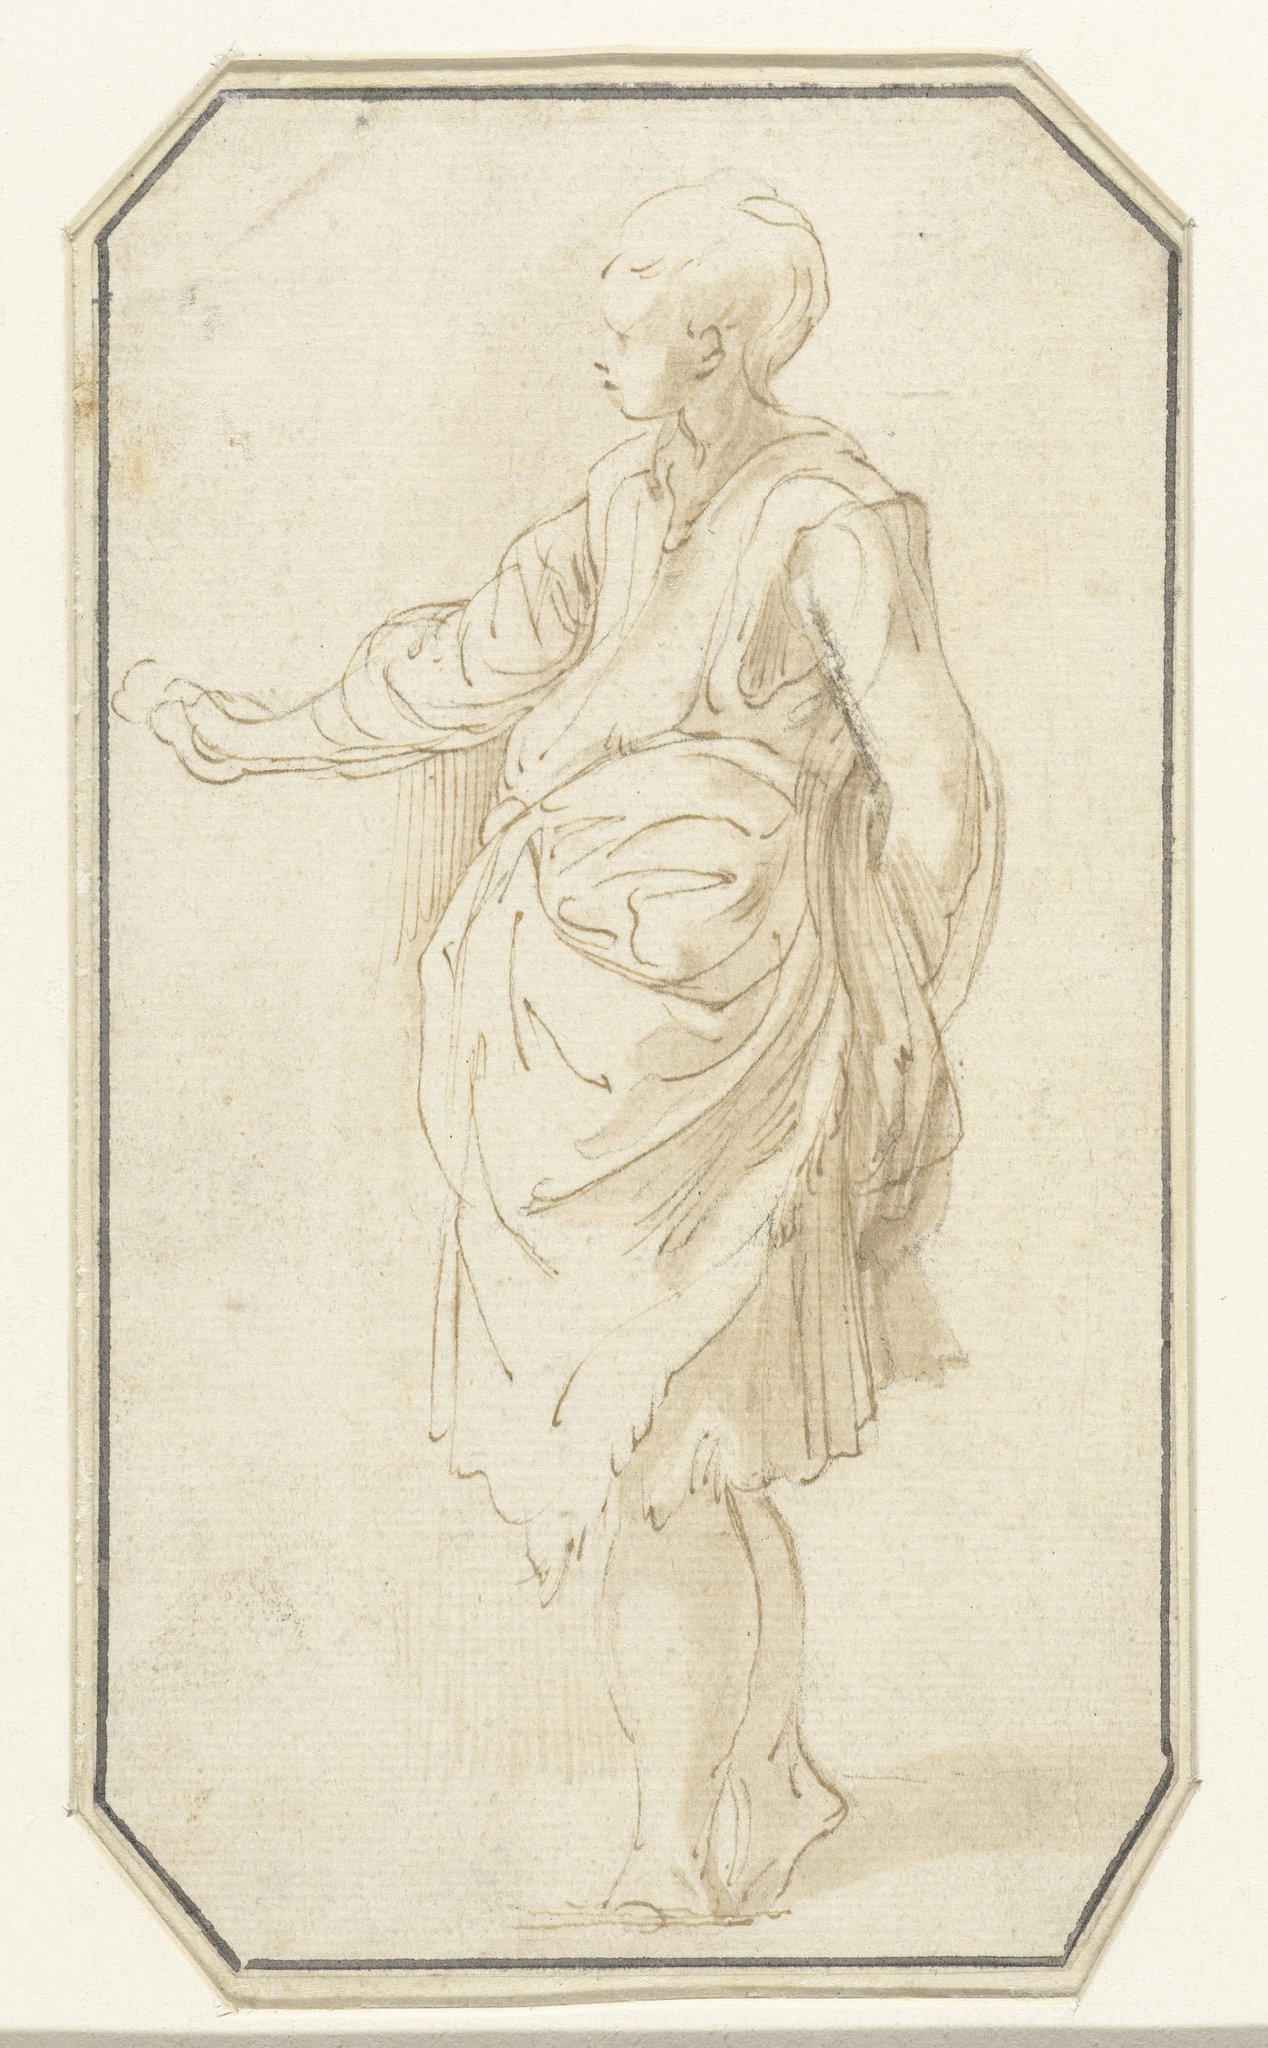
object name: drawing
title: Staande vrouw, naar links gewend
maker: Anonymous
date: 1523-1620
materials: chalk, ink, paper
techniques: brush, pen